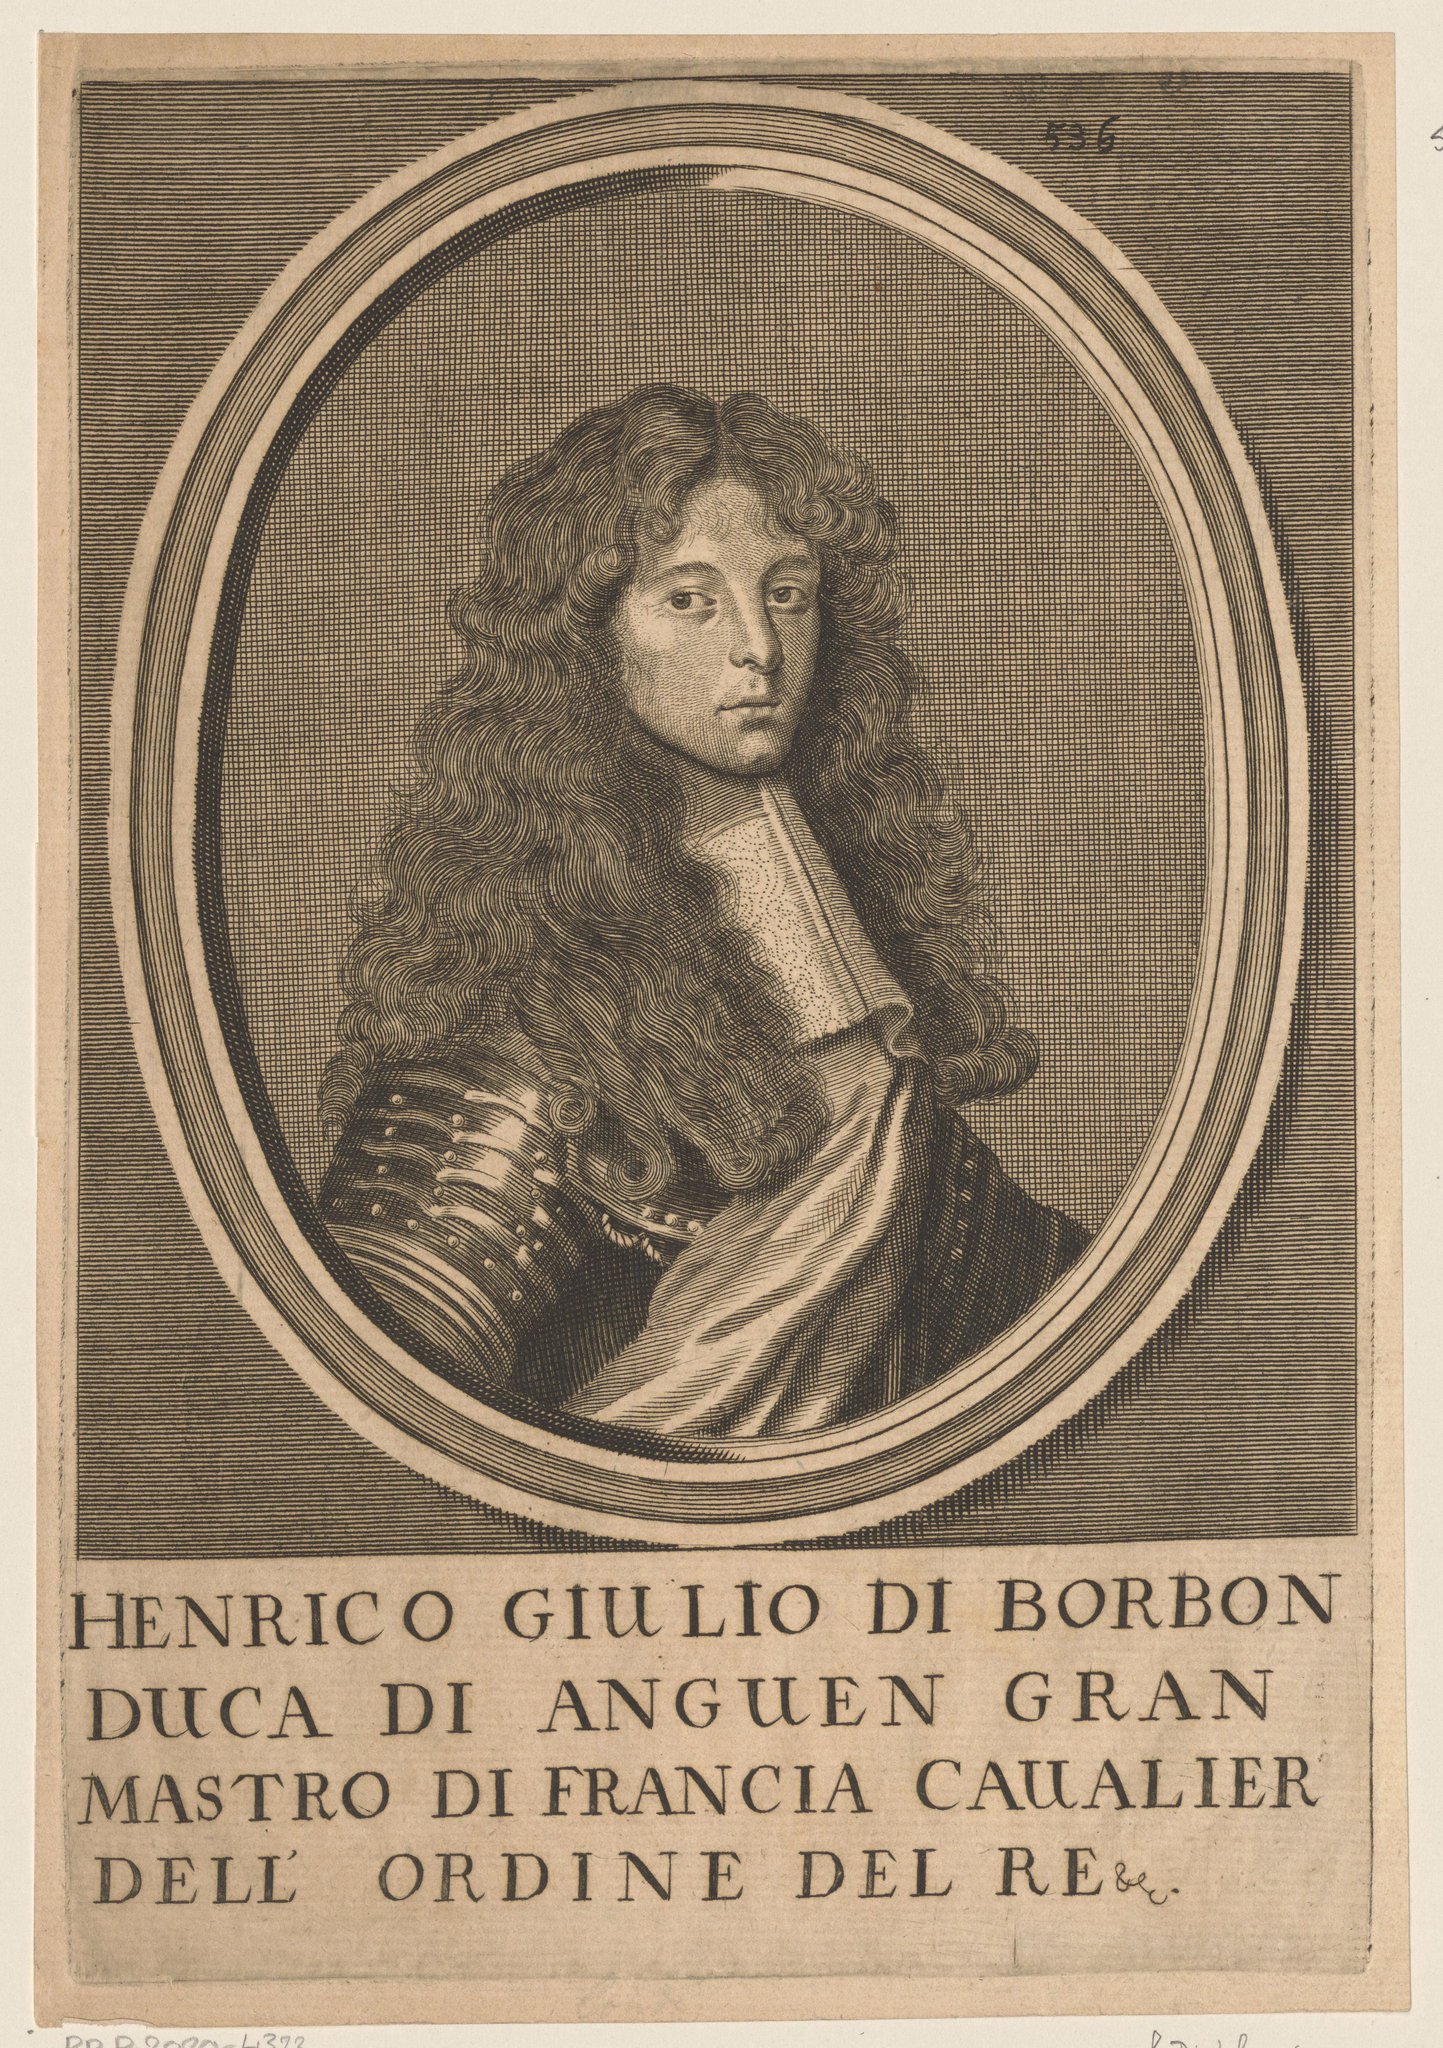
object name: print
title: Portret van Henri-Jules de Bourbon, prins van Condé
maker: Anonymous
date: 1630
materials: paper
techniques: engraving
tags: paris, historical persons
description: Prent mogelijk uit: Historia di Leopoldo Cesare (...). Wenen: Giovanni Battista Hacque, 1630, dl. 2.